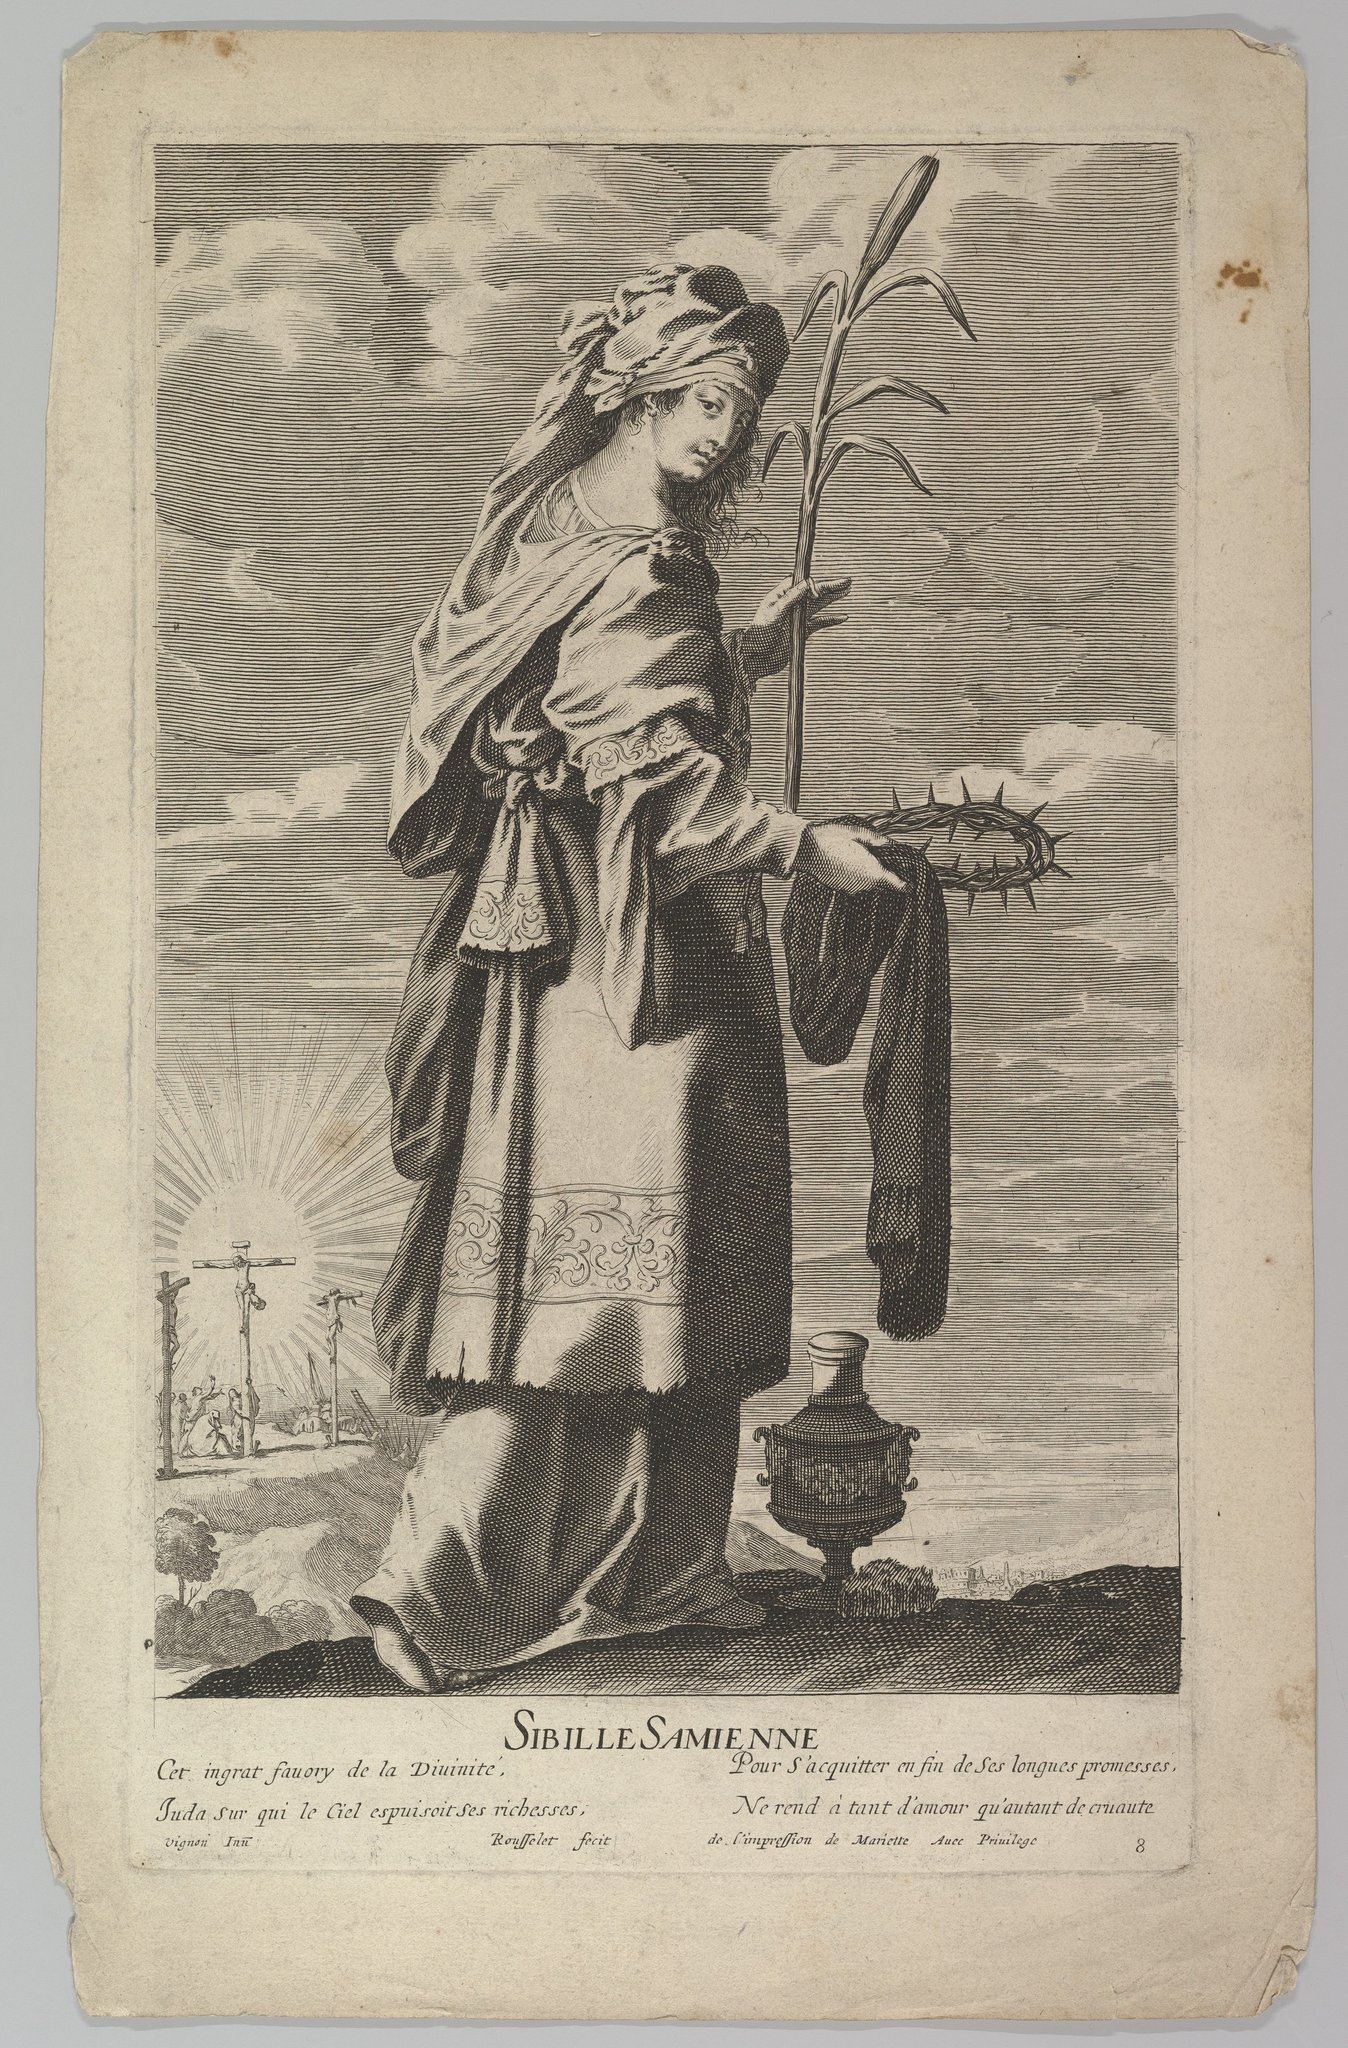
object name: print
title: Sibylle Samienne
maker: gilles rousselet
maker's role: artist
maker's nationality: french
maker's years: 1614-1686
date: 1635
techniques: engraving, etching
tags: portraits,women